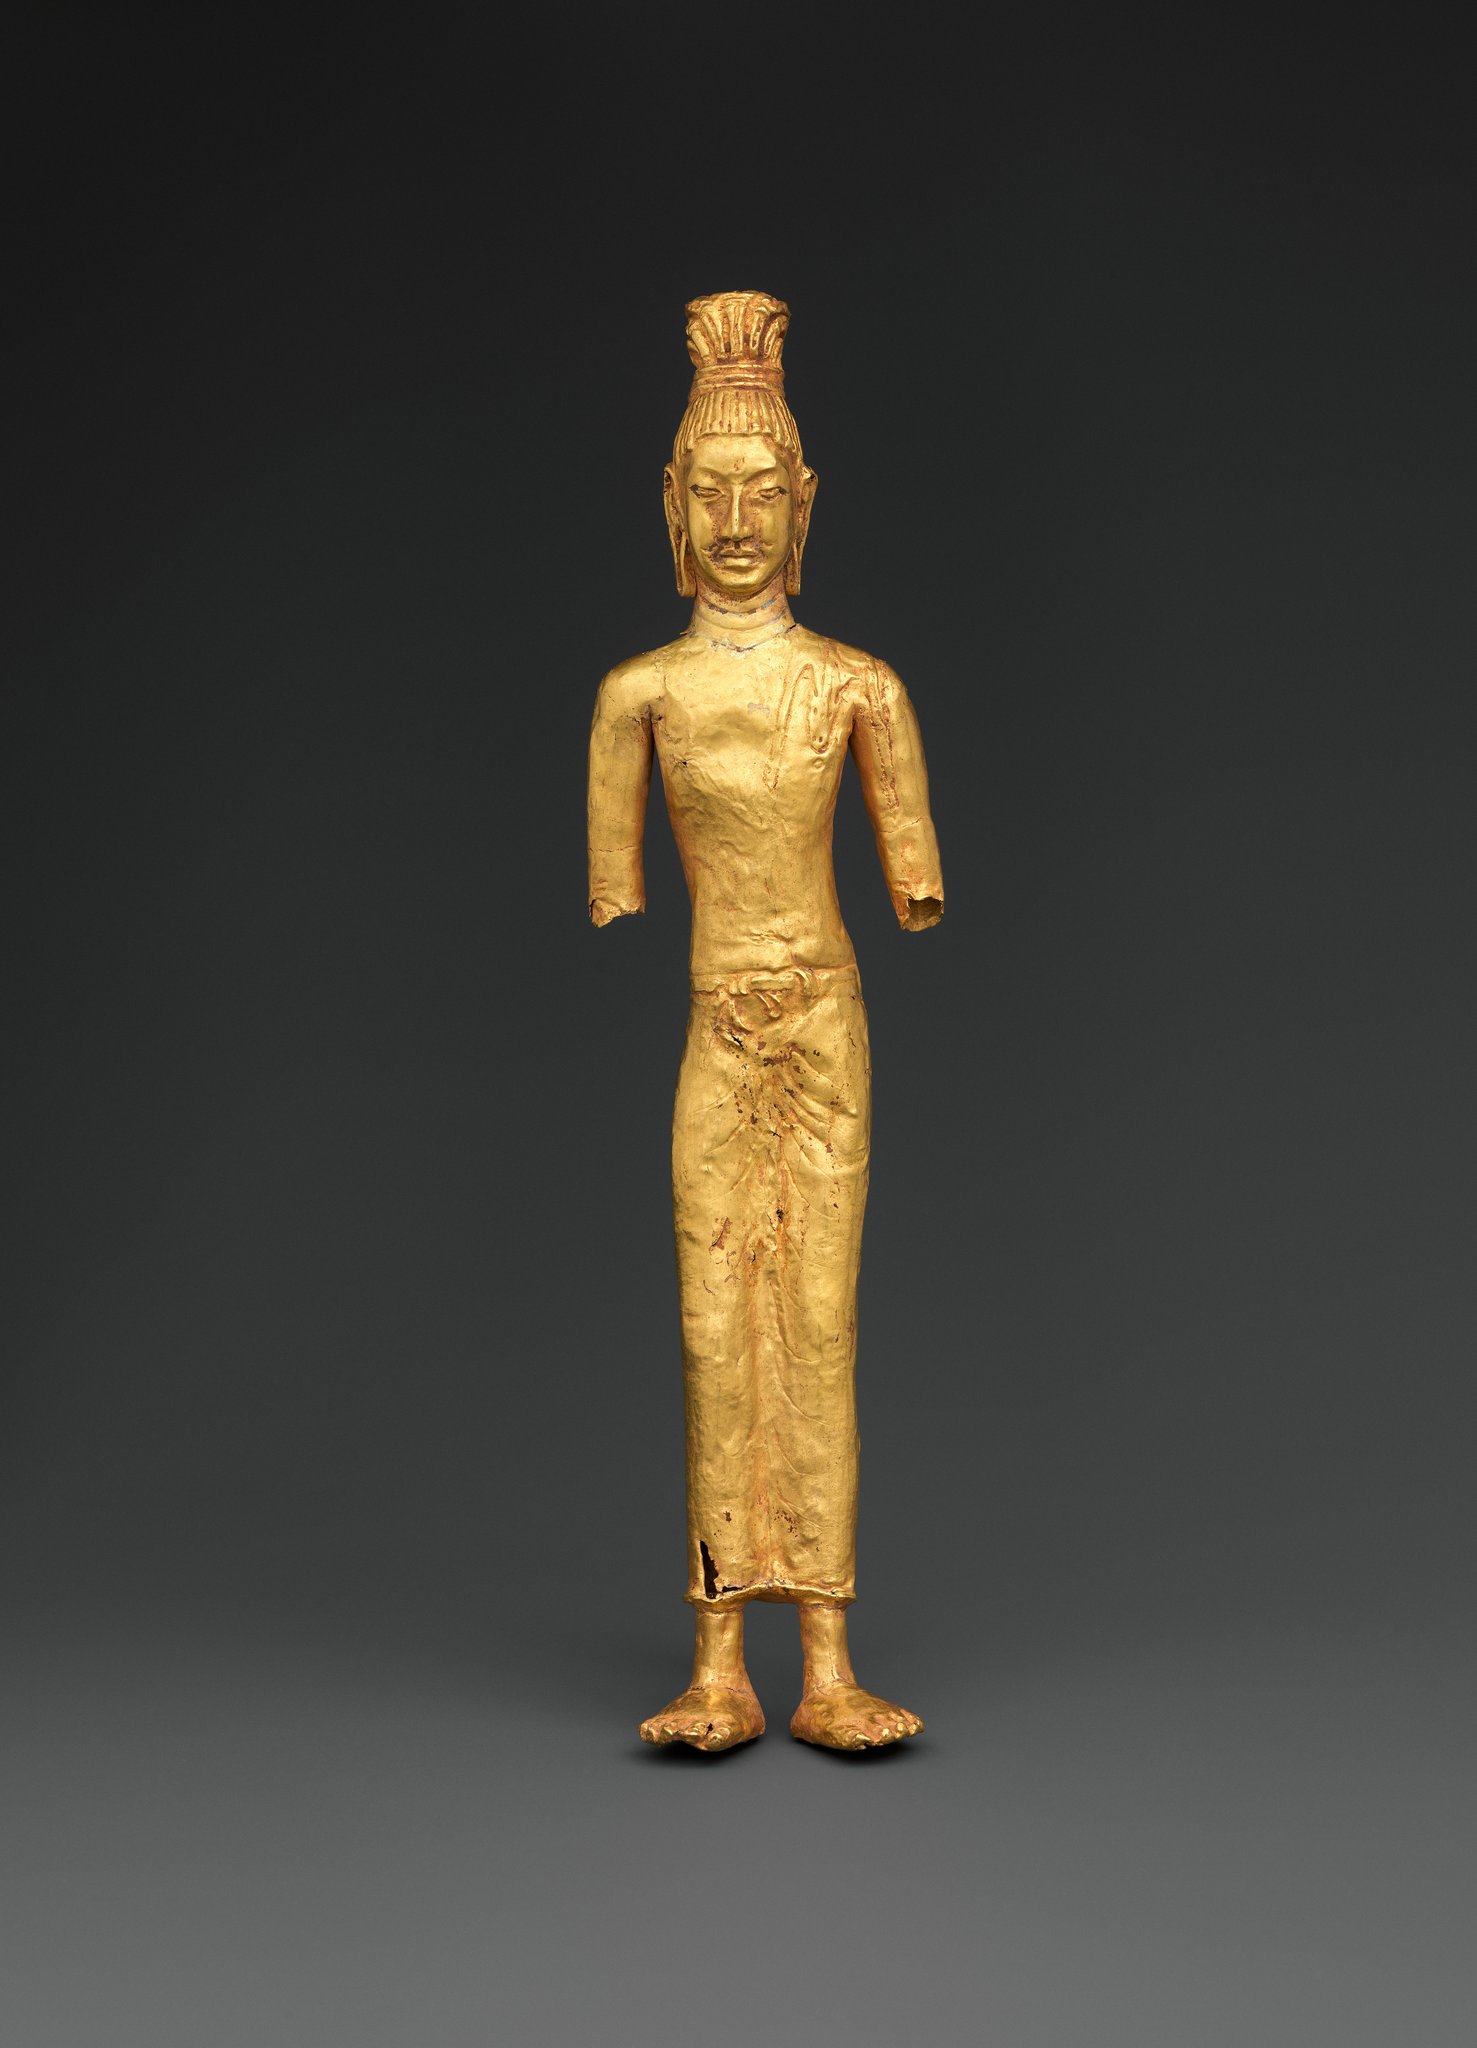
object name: figure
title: Standing Avalokiteshvara, the Bodhisattva of Infinite Compassion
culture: thai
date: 701-900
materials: gold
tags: buddhism,avalokiteshvara,bodhisattvas